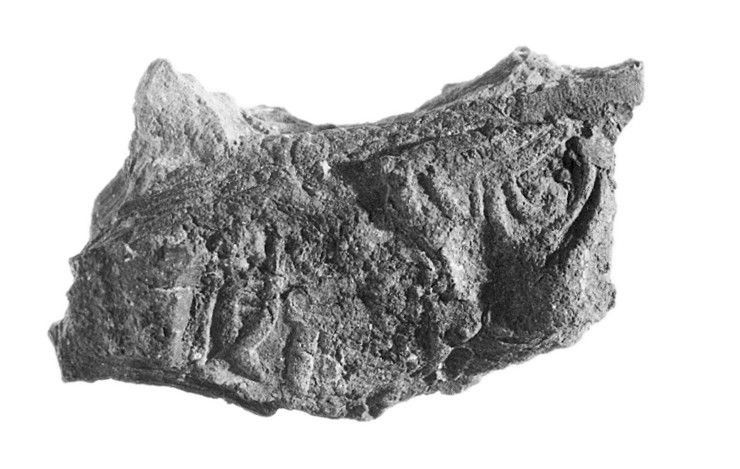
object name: sealing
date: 1981-1640 BCE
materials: mud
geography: egypt